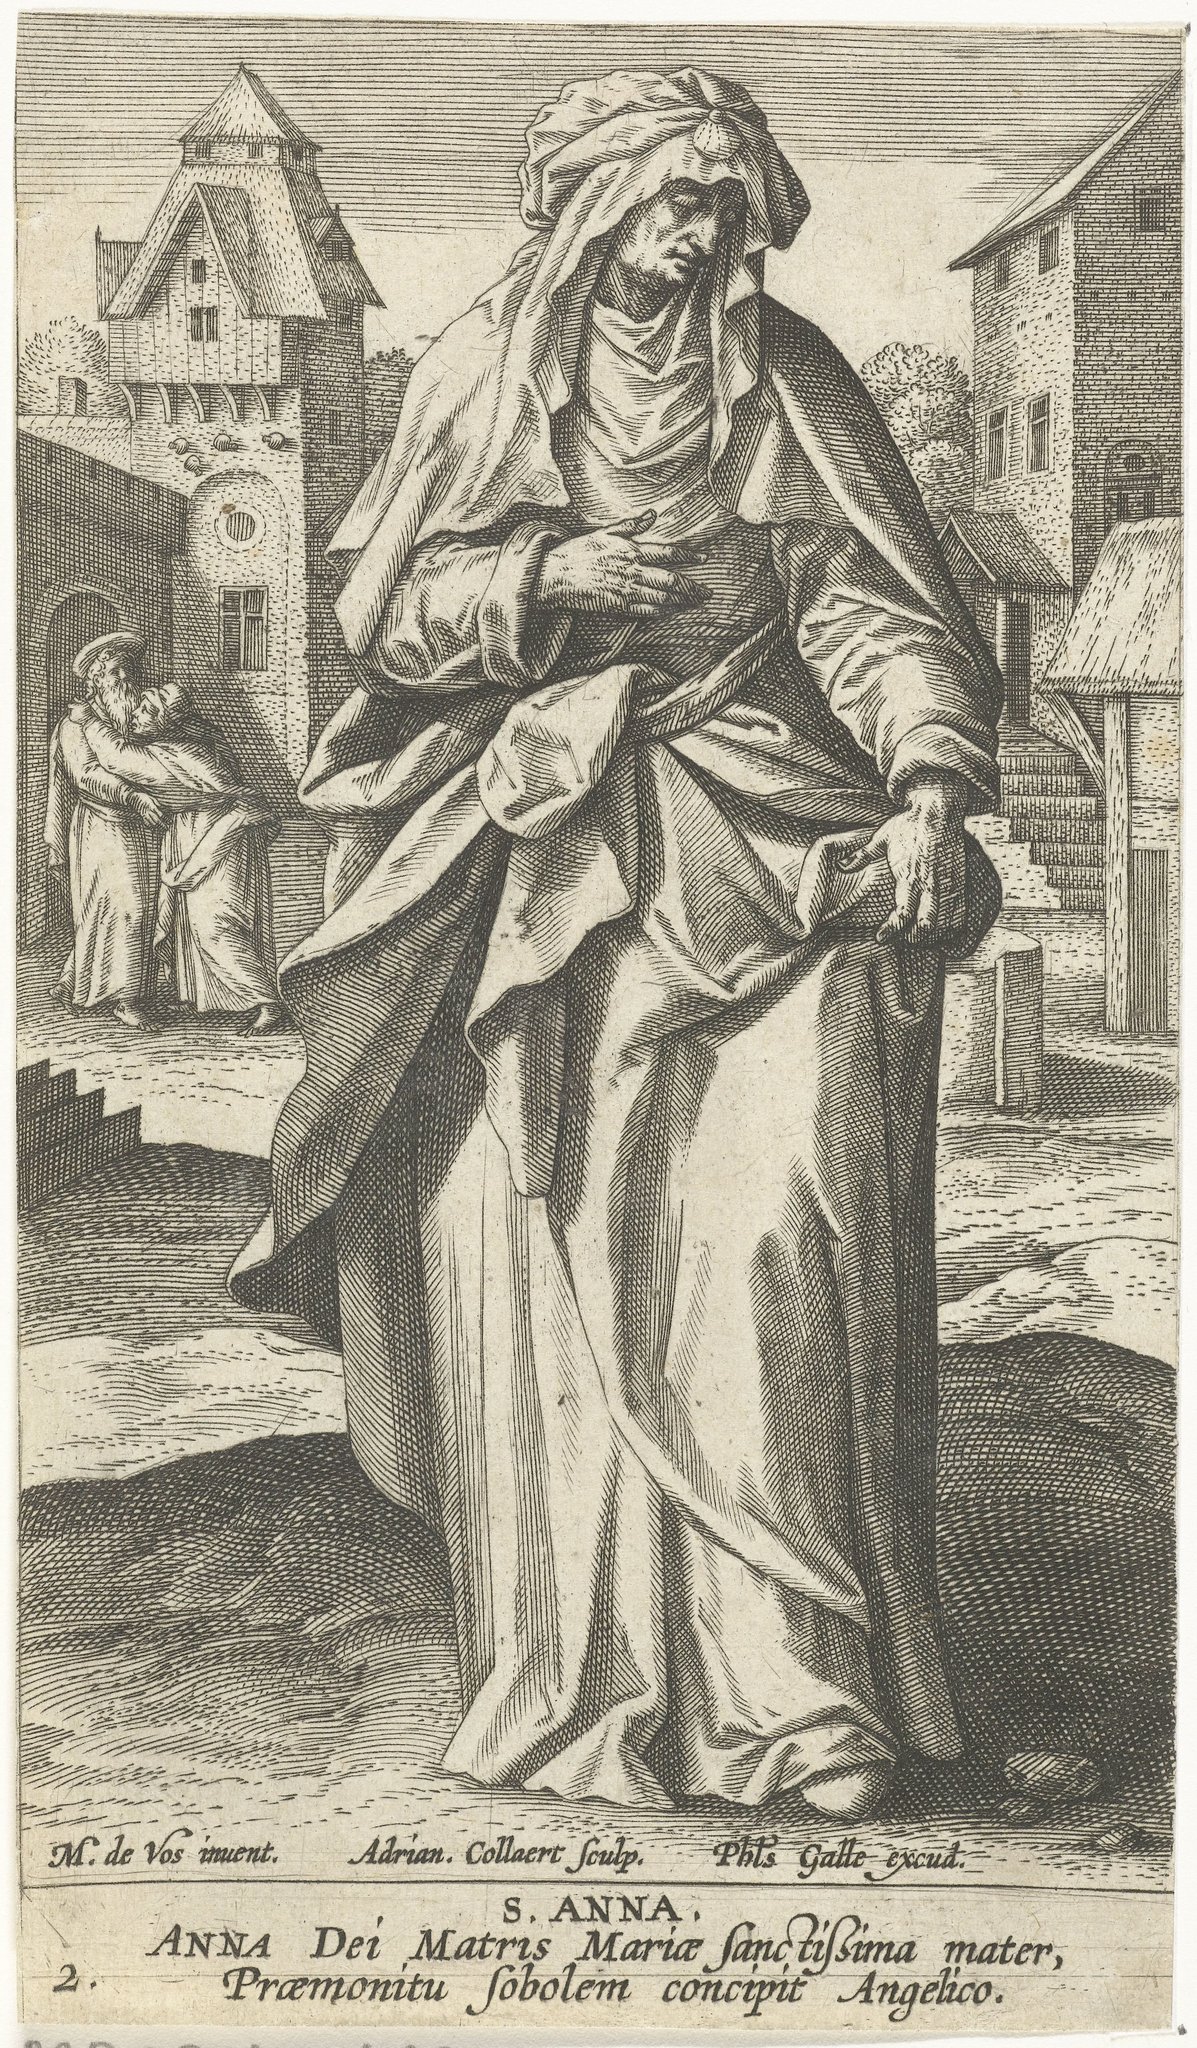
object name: print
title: Heilige Anna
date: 1595-1599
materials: paper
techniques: engraving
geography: antwerp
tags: meeting of anna and joachim at the golden gate; they usually embrace or kiss each other (immaculate conception of mary), female persons from the new testament (with name) (not in biblical context)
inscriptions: collector's mark: Lugt 2228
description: Op de voorgrond Anna, de moeder van de maagd Maria. Op de achtergrond de ontmoeting tussen Anna en haar man Joachim bij de poorten van Jeruzalem. De prent heeft een Latijns onderschrift en maakt deel uit van een prentserie met beroemde vrouwen uit het Nieuwe Testament.